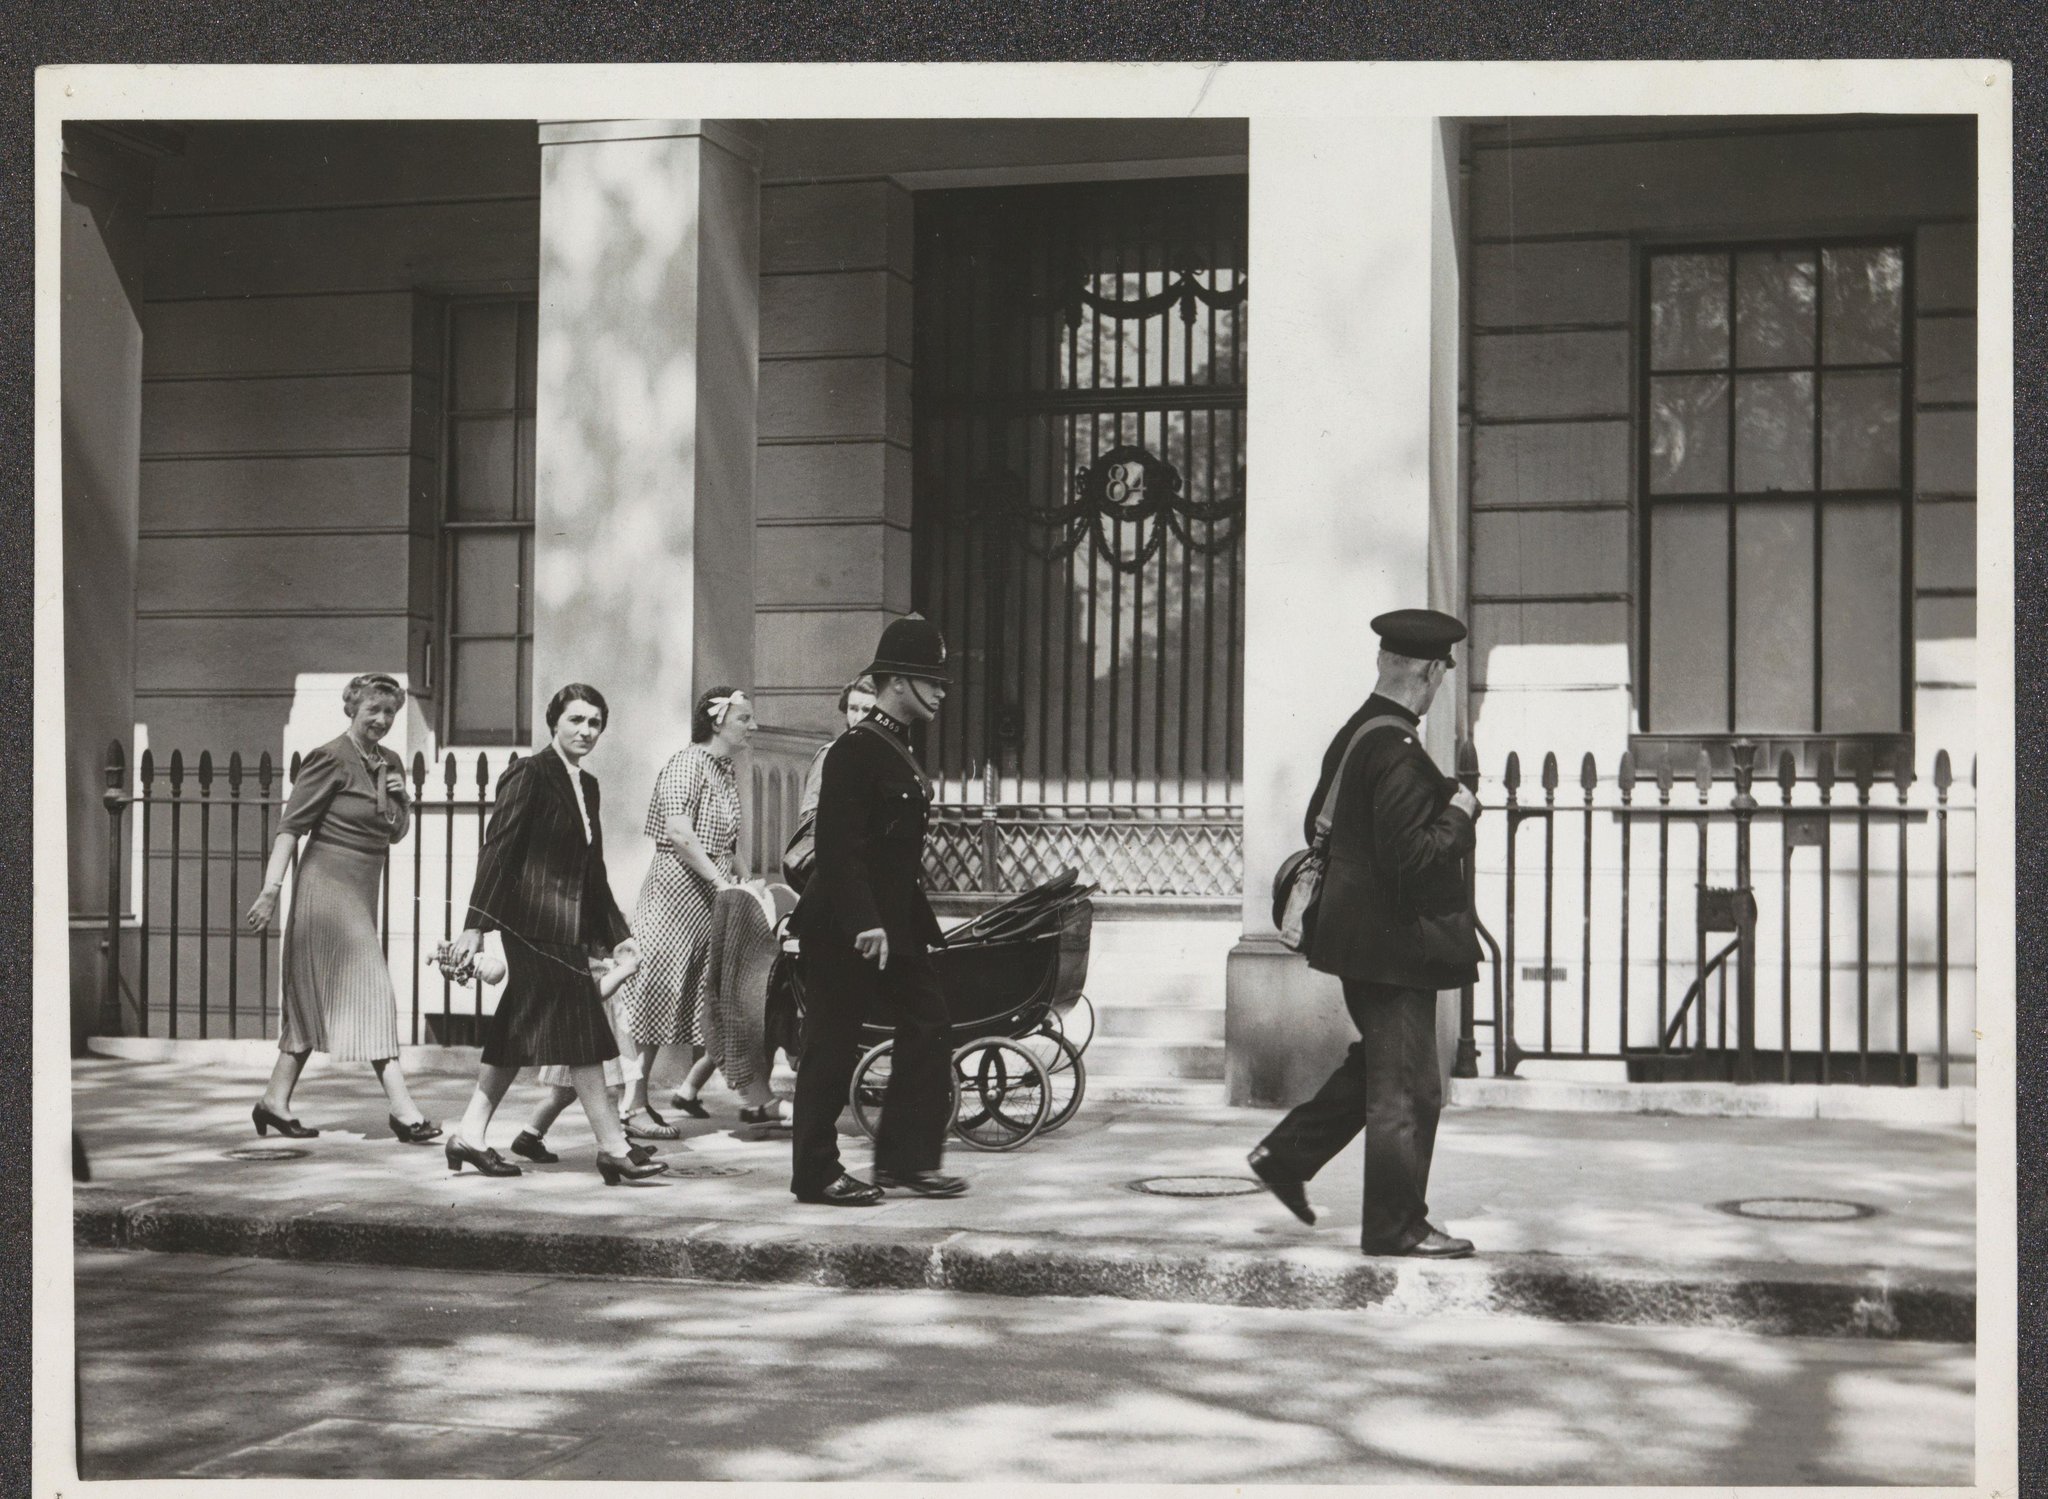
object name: photograph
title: Koningin Juliana loopt met kinderwagen en gevolg door Londen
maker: Anonymous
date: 1940-1945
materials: photographic support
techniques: gelatin silver print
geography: london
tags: the hague, juliana of the netherlands, historical persons - bb - woman, queen, london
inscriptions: stamp: ‘photograph by The Topical Press Agency LTD’, inscription: ‘H.I.E. PRF. 19 9704’, stamp: ‘Photo archief R.V.D.’